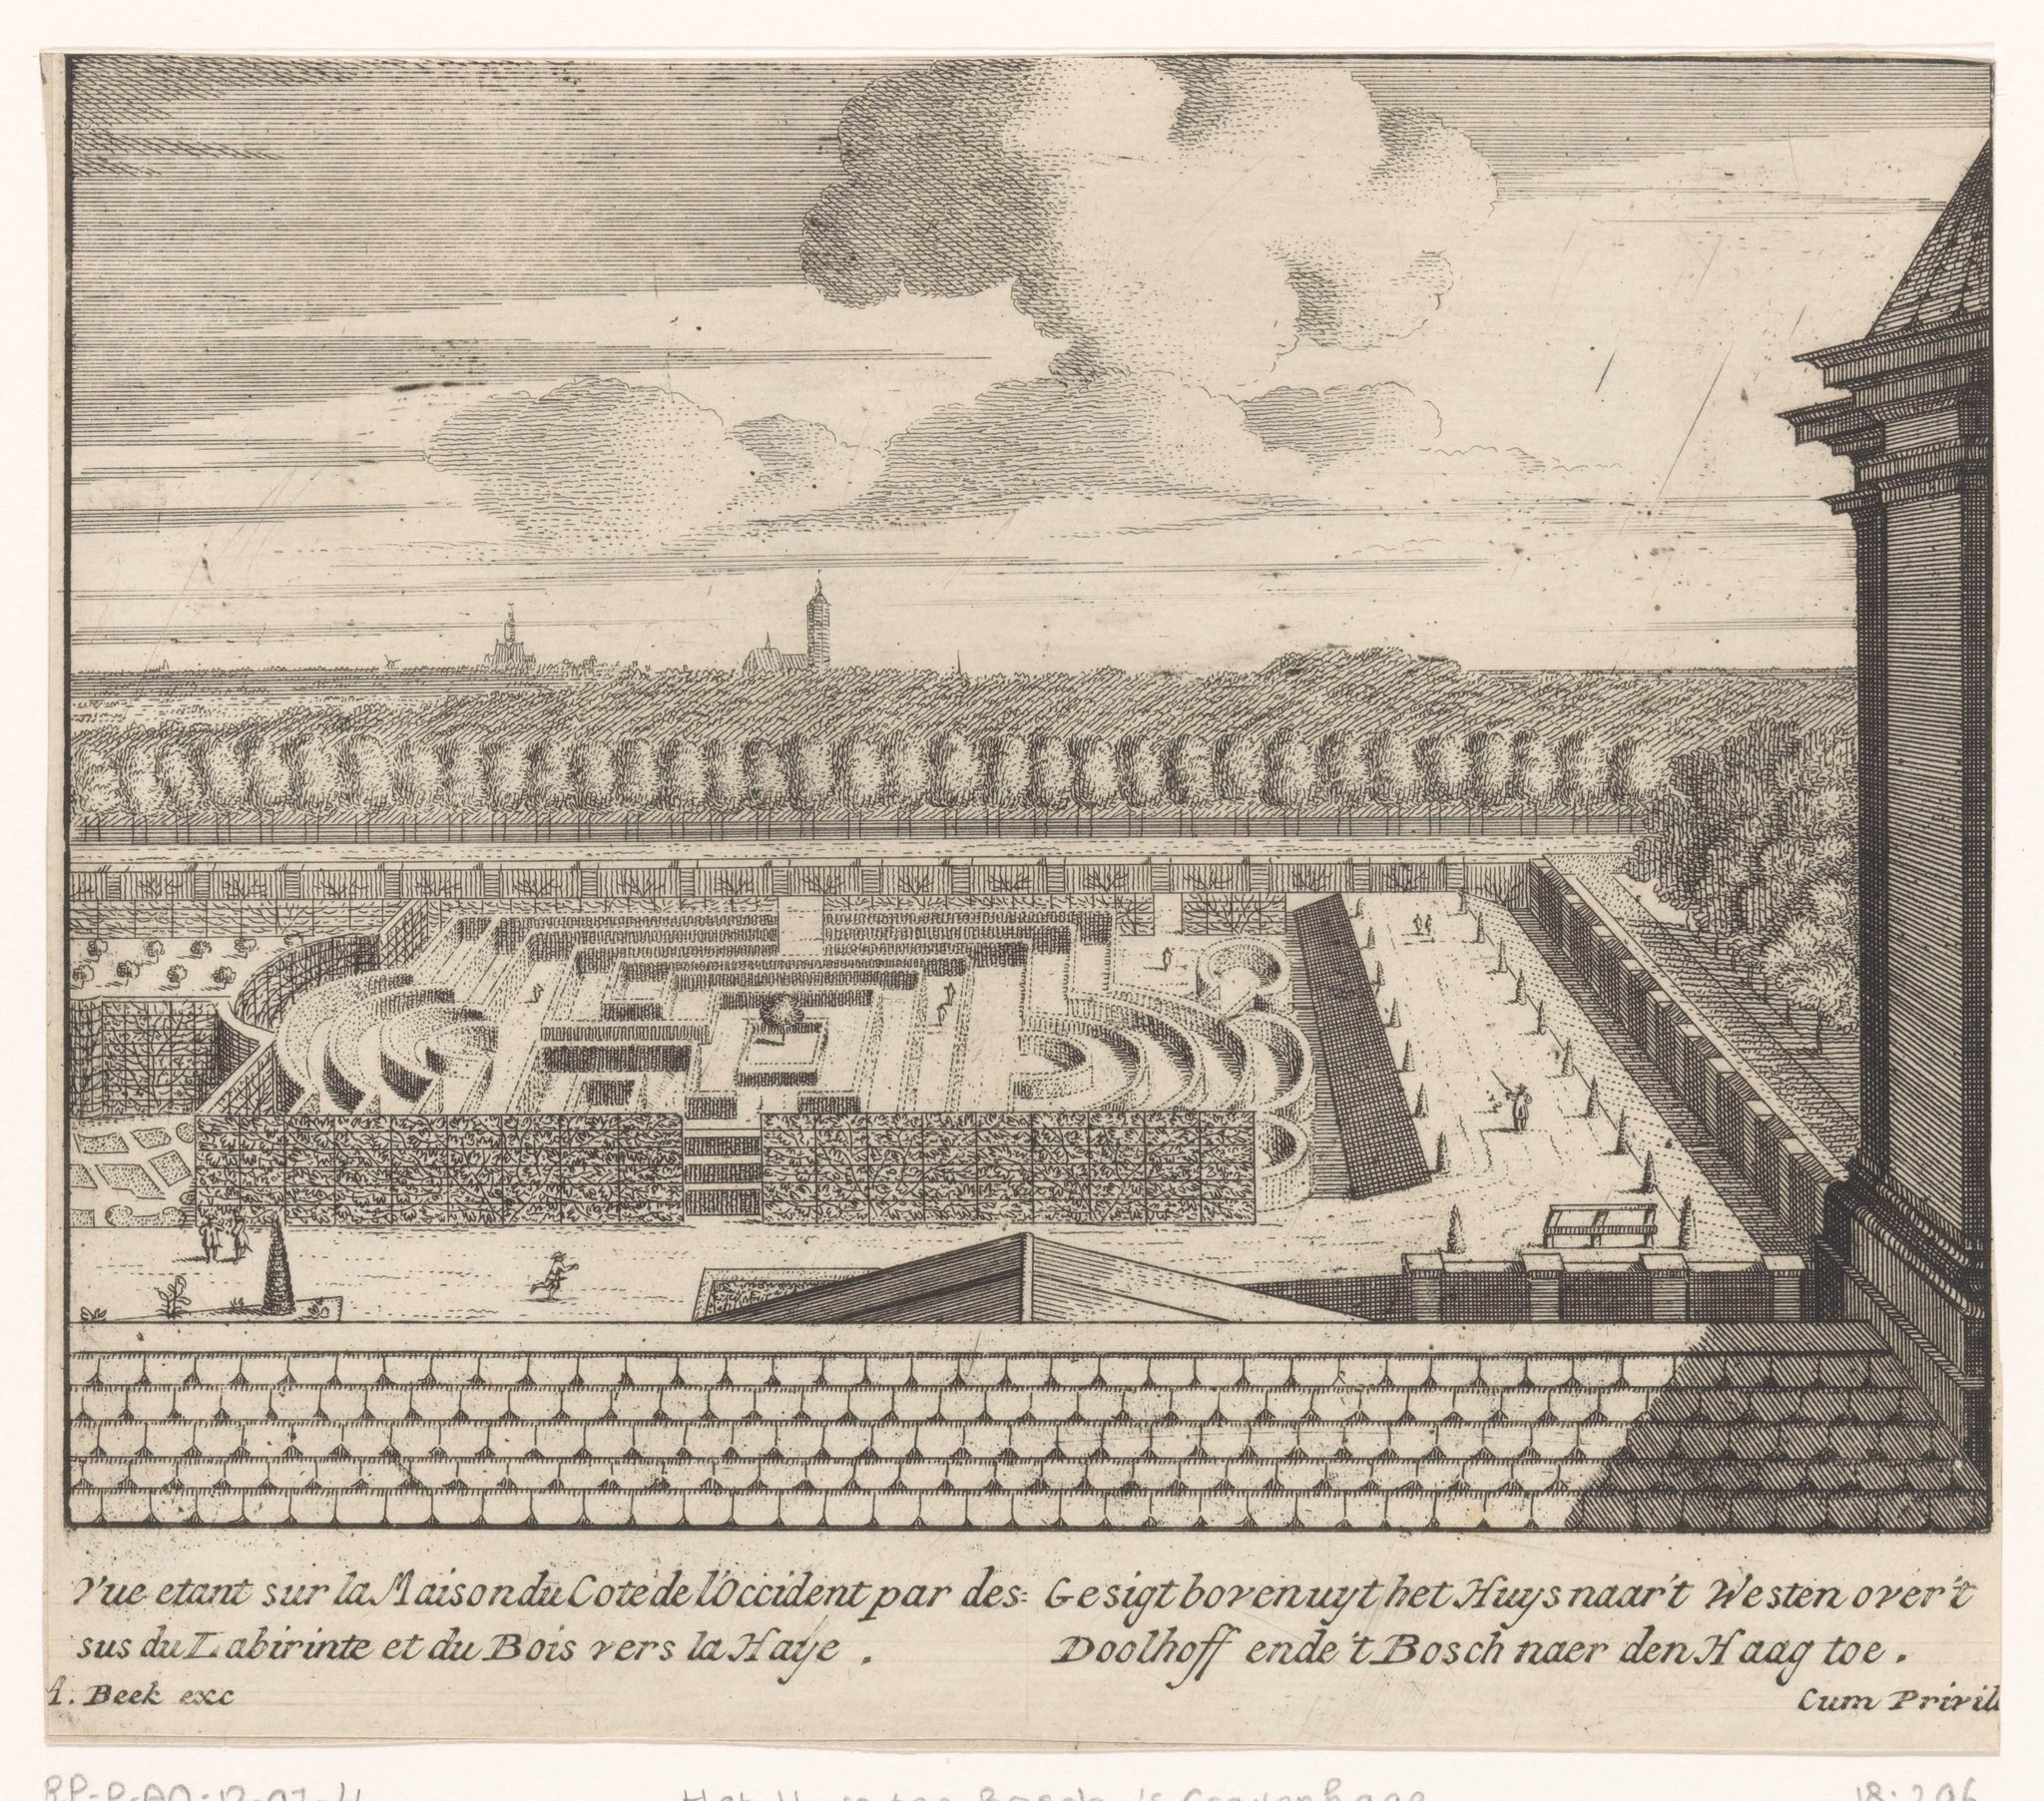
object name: print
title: Gesigt boven uyt het huys naar 't westen over 't doolhoff ende 't bosch naer Den Haag toe / Vue etant sur la maison du cote de l'occident par dessus du labirinte et du bois vers La Haye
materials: paper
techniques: etching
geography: the hague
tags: prospect of village, silhouette of village, palace, french or architectonic garden; formal garden, labyrinth, maze ~ garden, prospect of city, town panorama, silhouette of city, the hague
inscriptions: collector's mark: Lugt 2228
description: Mogelijk uitgegeven als onderdeel van een serie van zestien prenten en een panorama van Huis ten Bosch. Zie ook RP-P-AO-12-97-1, RP-P-AO-12-97-2, RP-P-AO-12-97-3, RP-P-AO-12-97-5, RP-P-AO-12-97-6, RP-P-AO-12-97-7, RP-P-AO-12-97-8, RP-P-AO-12-97-9, RP-P-AO-12-97-10, RP-P-AO-12-97-11, RP-P-AO-12-97-12, RP-P-AO-12-97-13, RP-P-AO-12-97-14 en RP-P-AO-12-97-15.